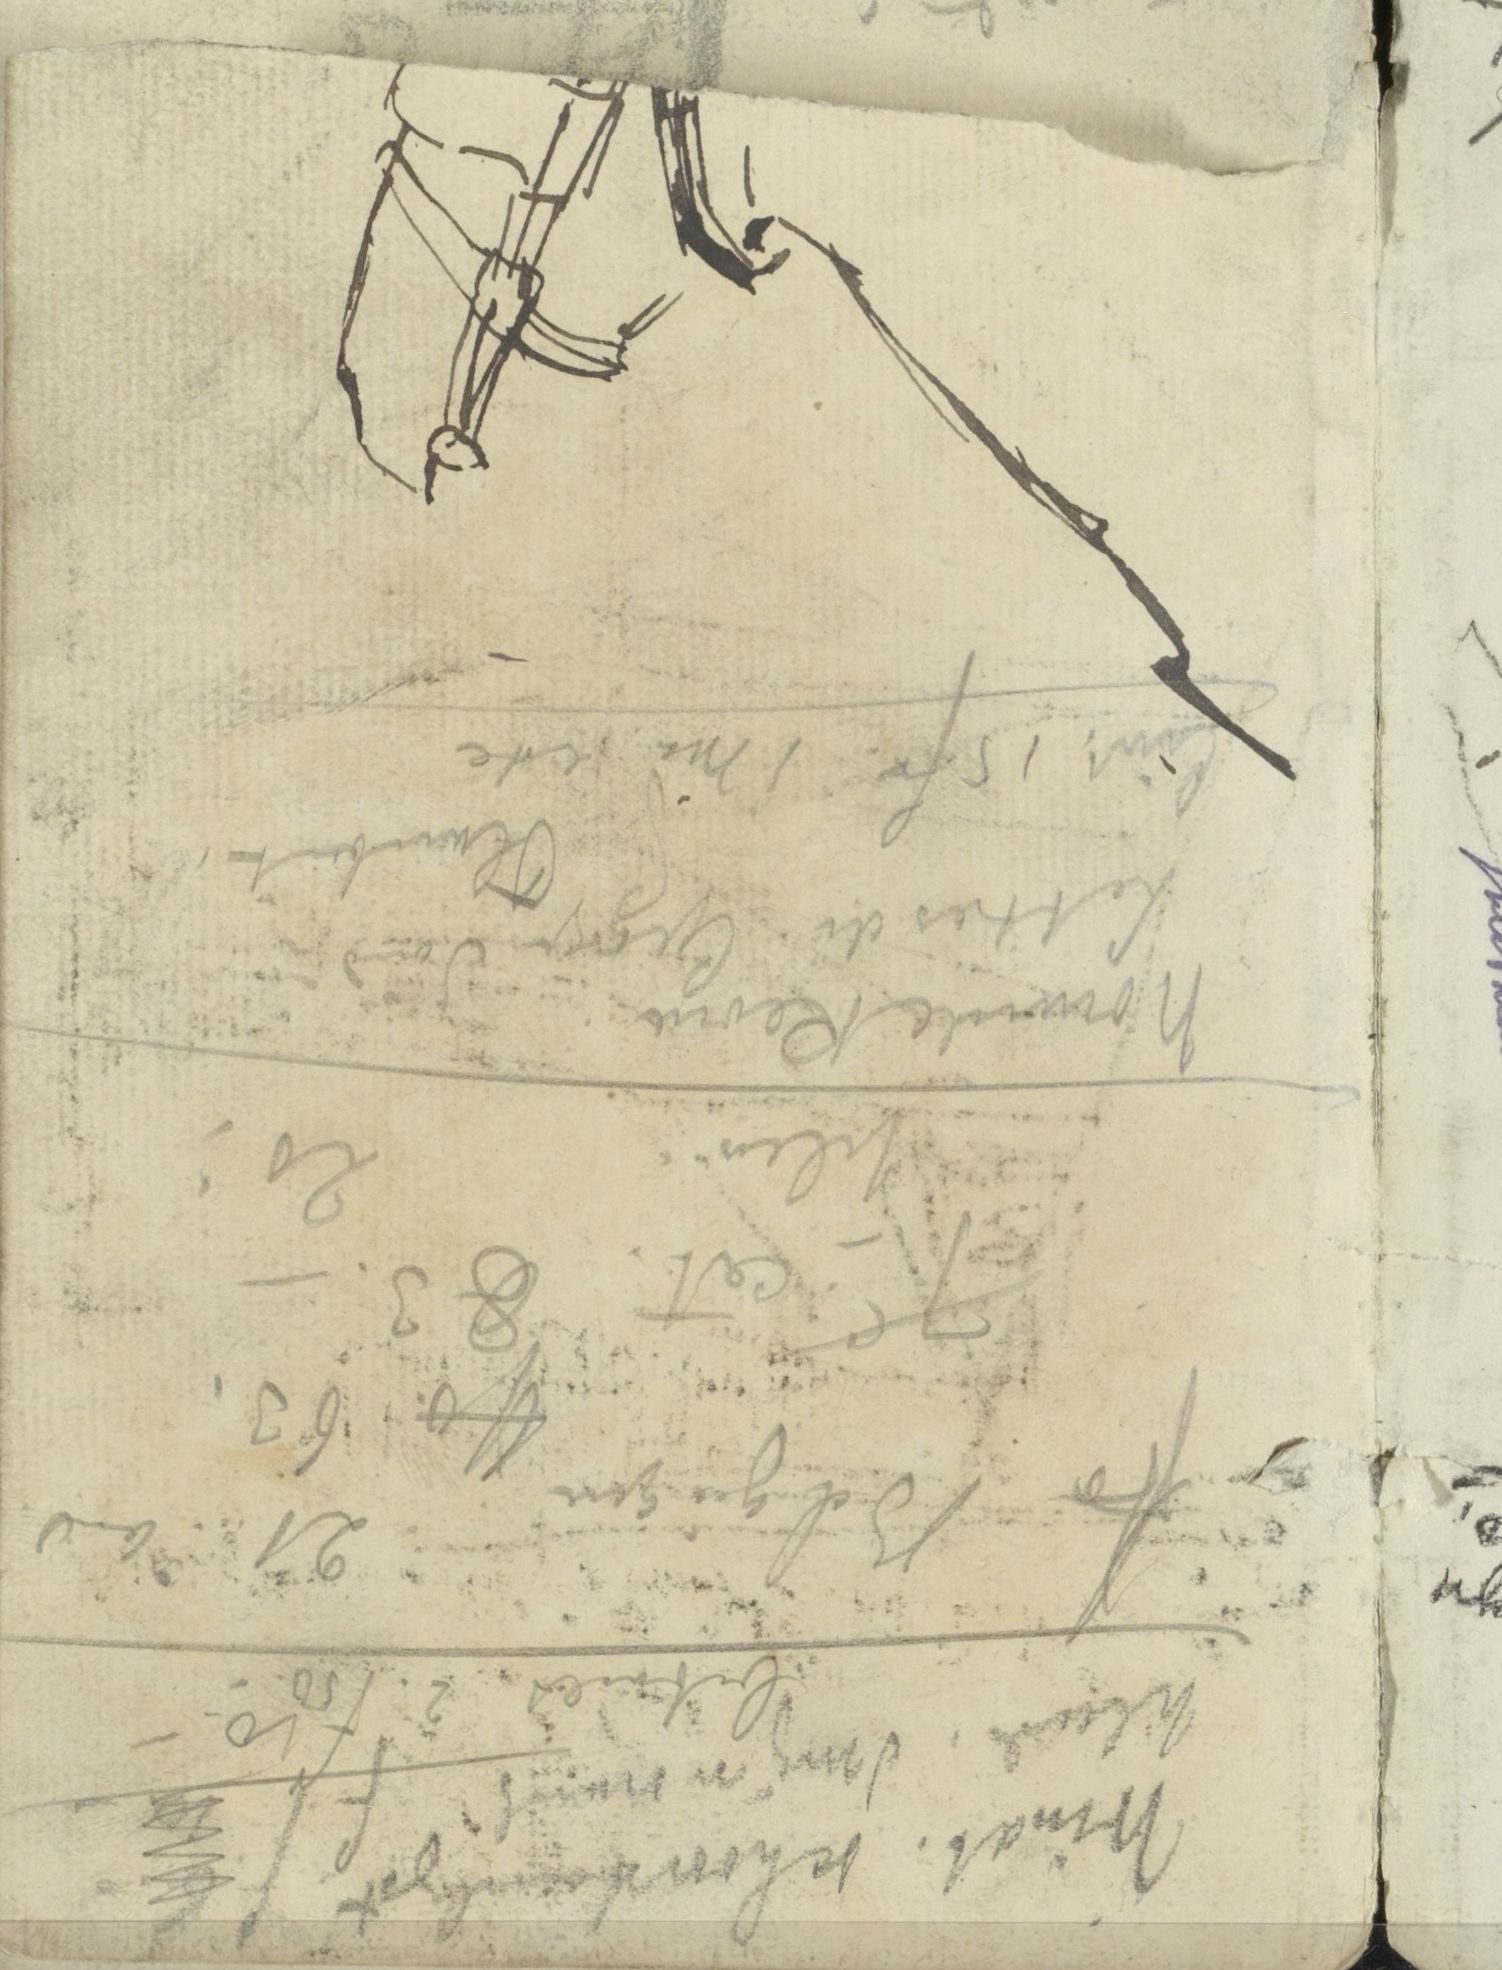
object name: sketchbook leaf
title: Paard met hoofdstel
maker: george hendrik breitner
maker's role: draughtsman, painter, print maker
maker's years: 1857-1923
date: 1887-1889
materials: ink, paper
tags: horse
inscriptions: annotation: ‘[...]/ Lettres de Georges Sand à/ Flaubert/ [...]’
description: Pagina 55 uit een schetsboek met 27 bladen.